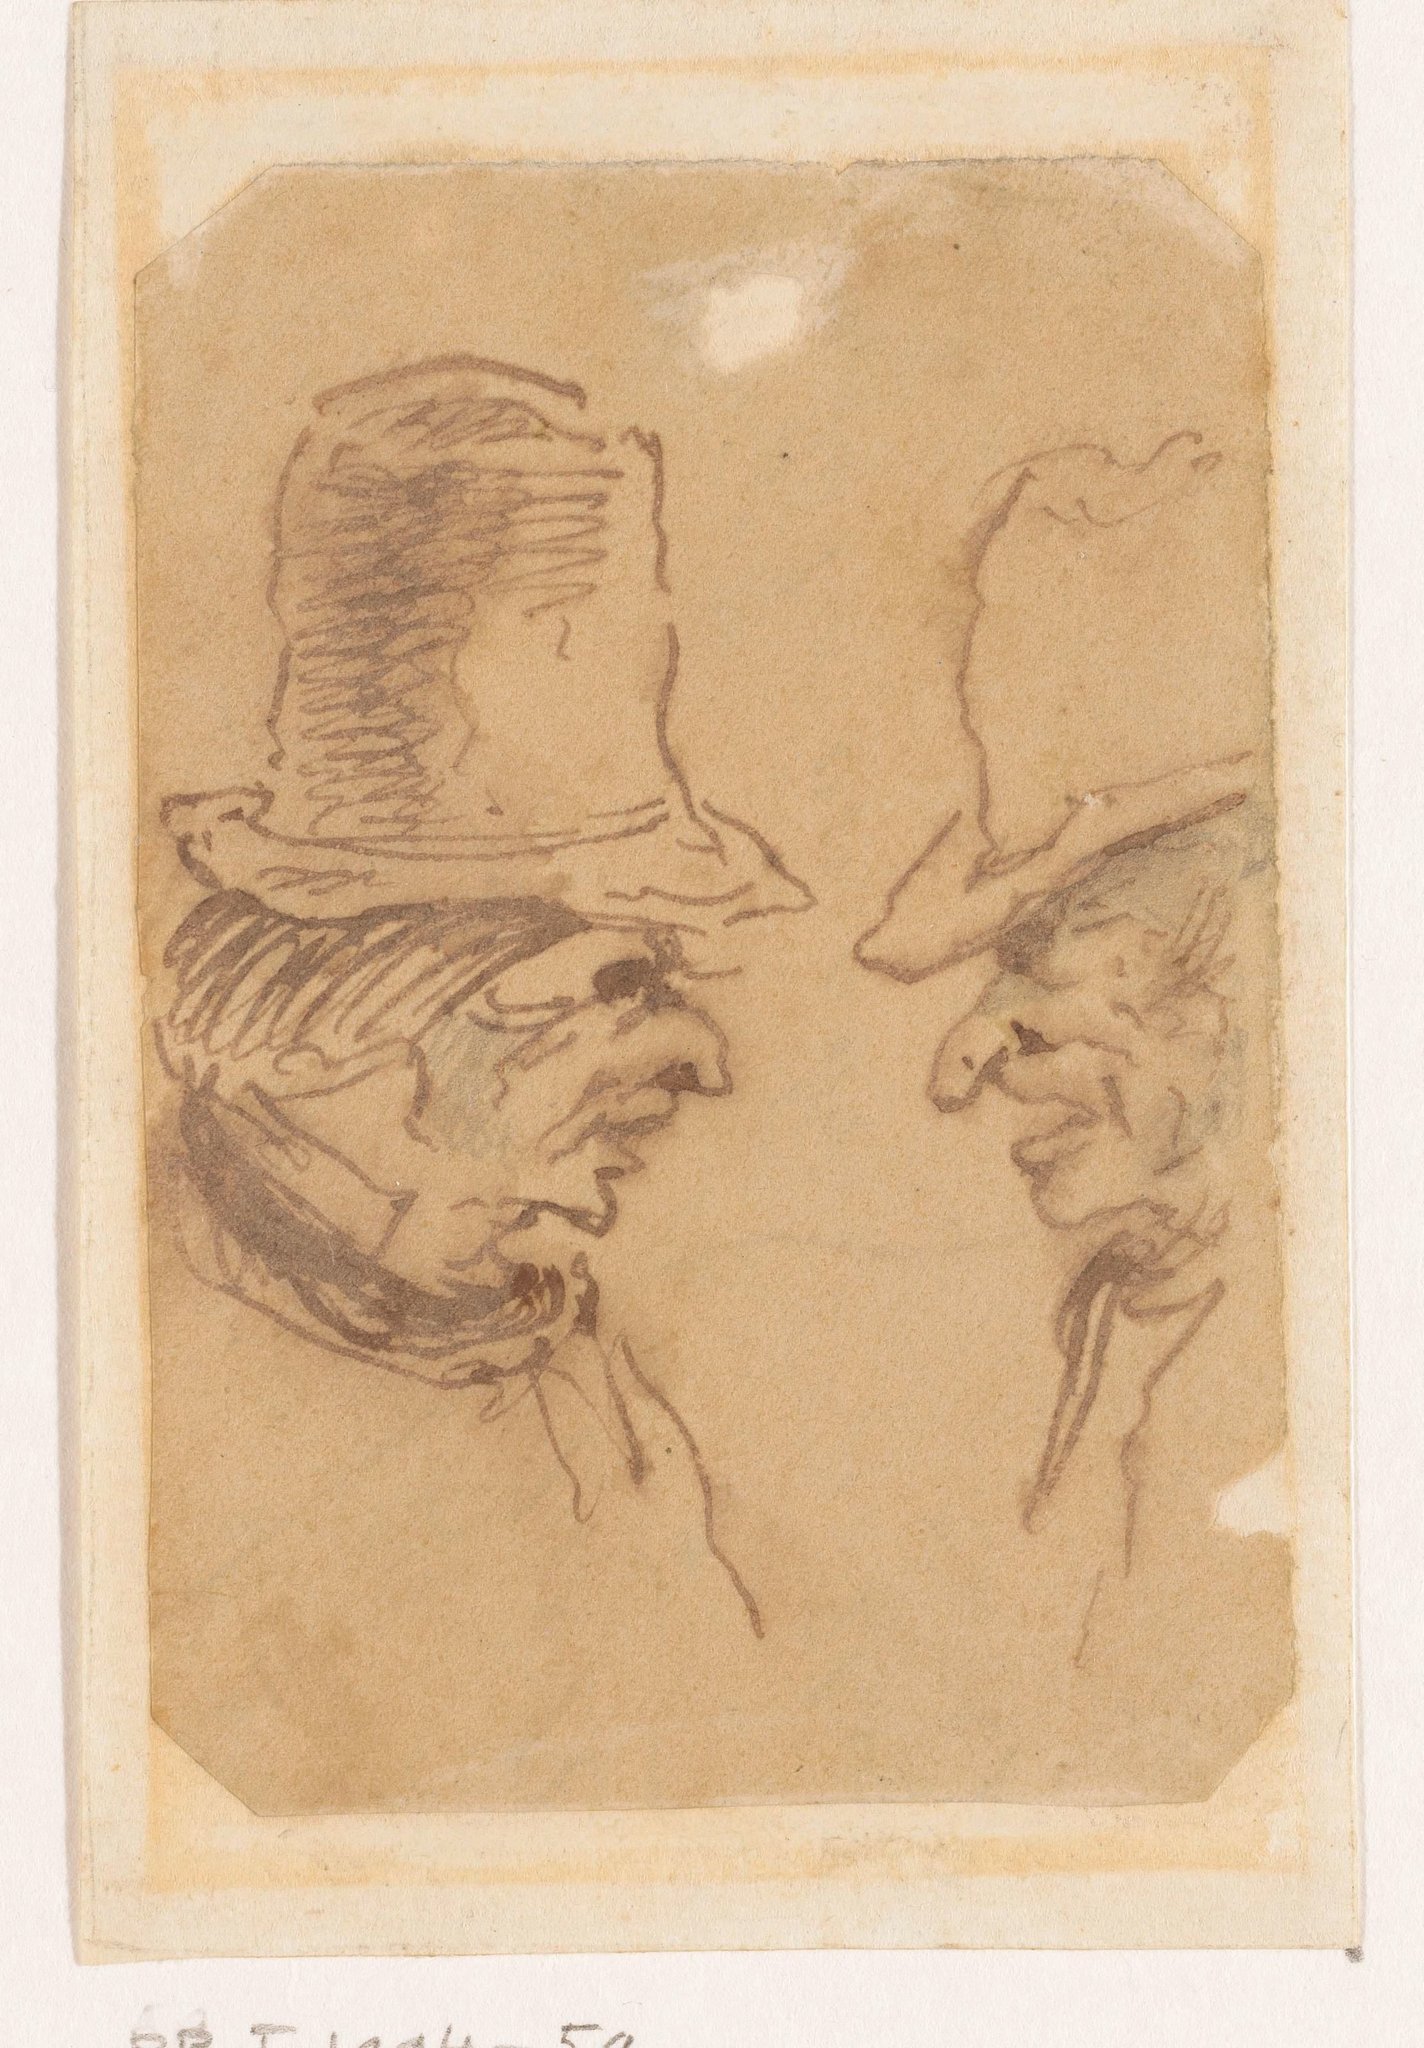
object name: drawing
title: Twee mannen met hoge hoeden, in gesprek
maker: johannes tavenraat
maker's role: draughtsman, painter, print maker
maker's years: 1809-1881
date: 1819-1881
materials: ink, paper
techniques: pen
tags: head-gear: top hat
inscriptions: annotation